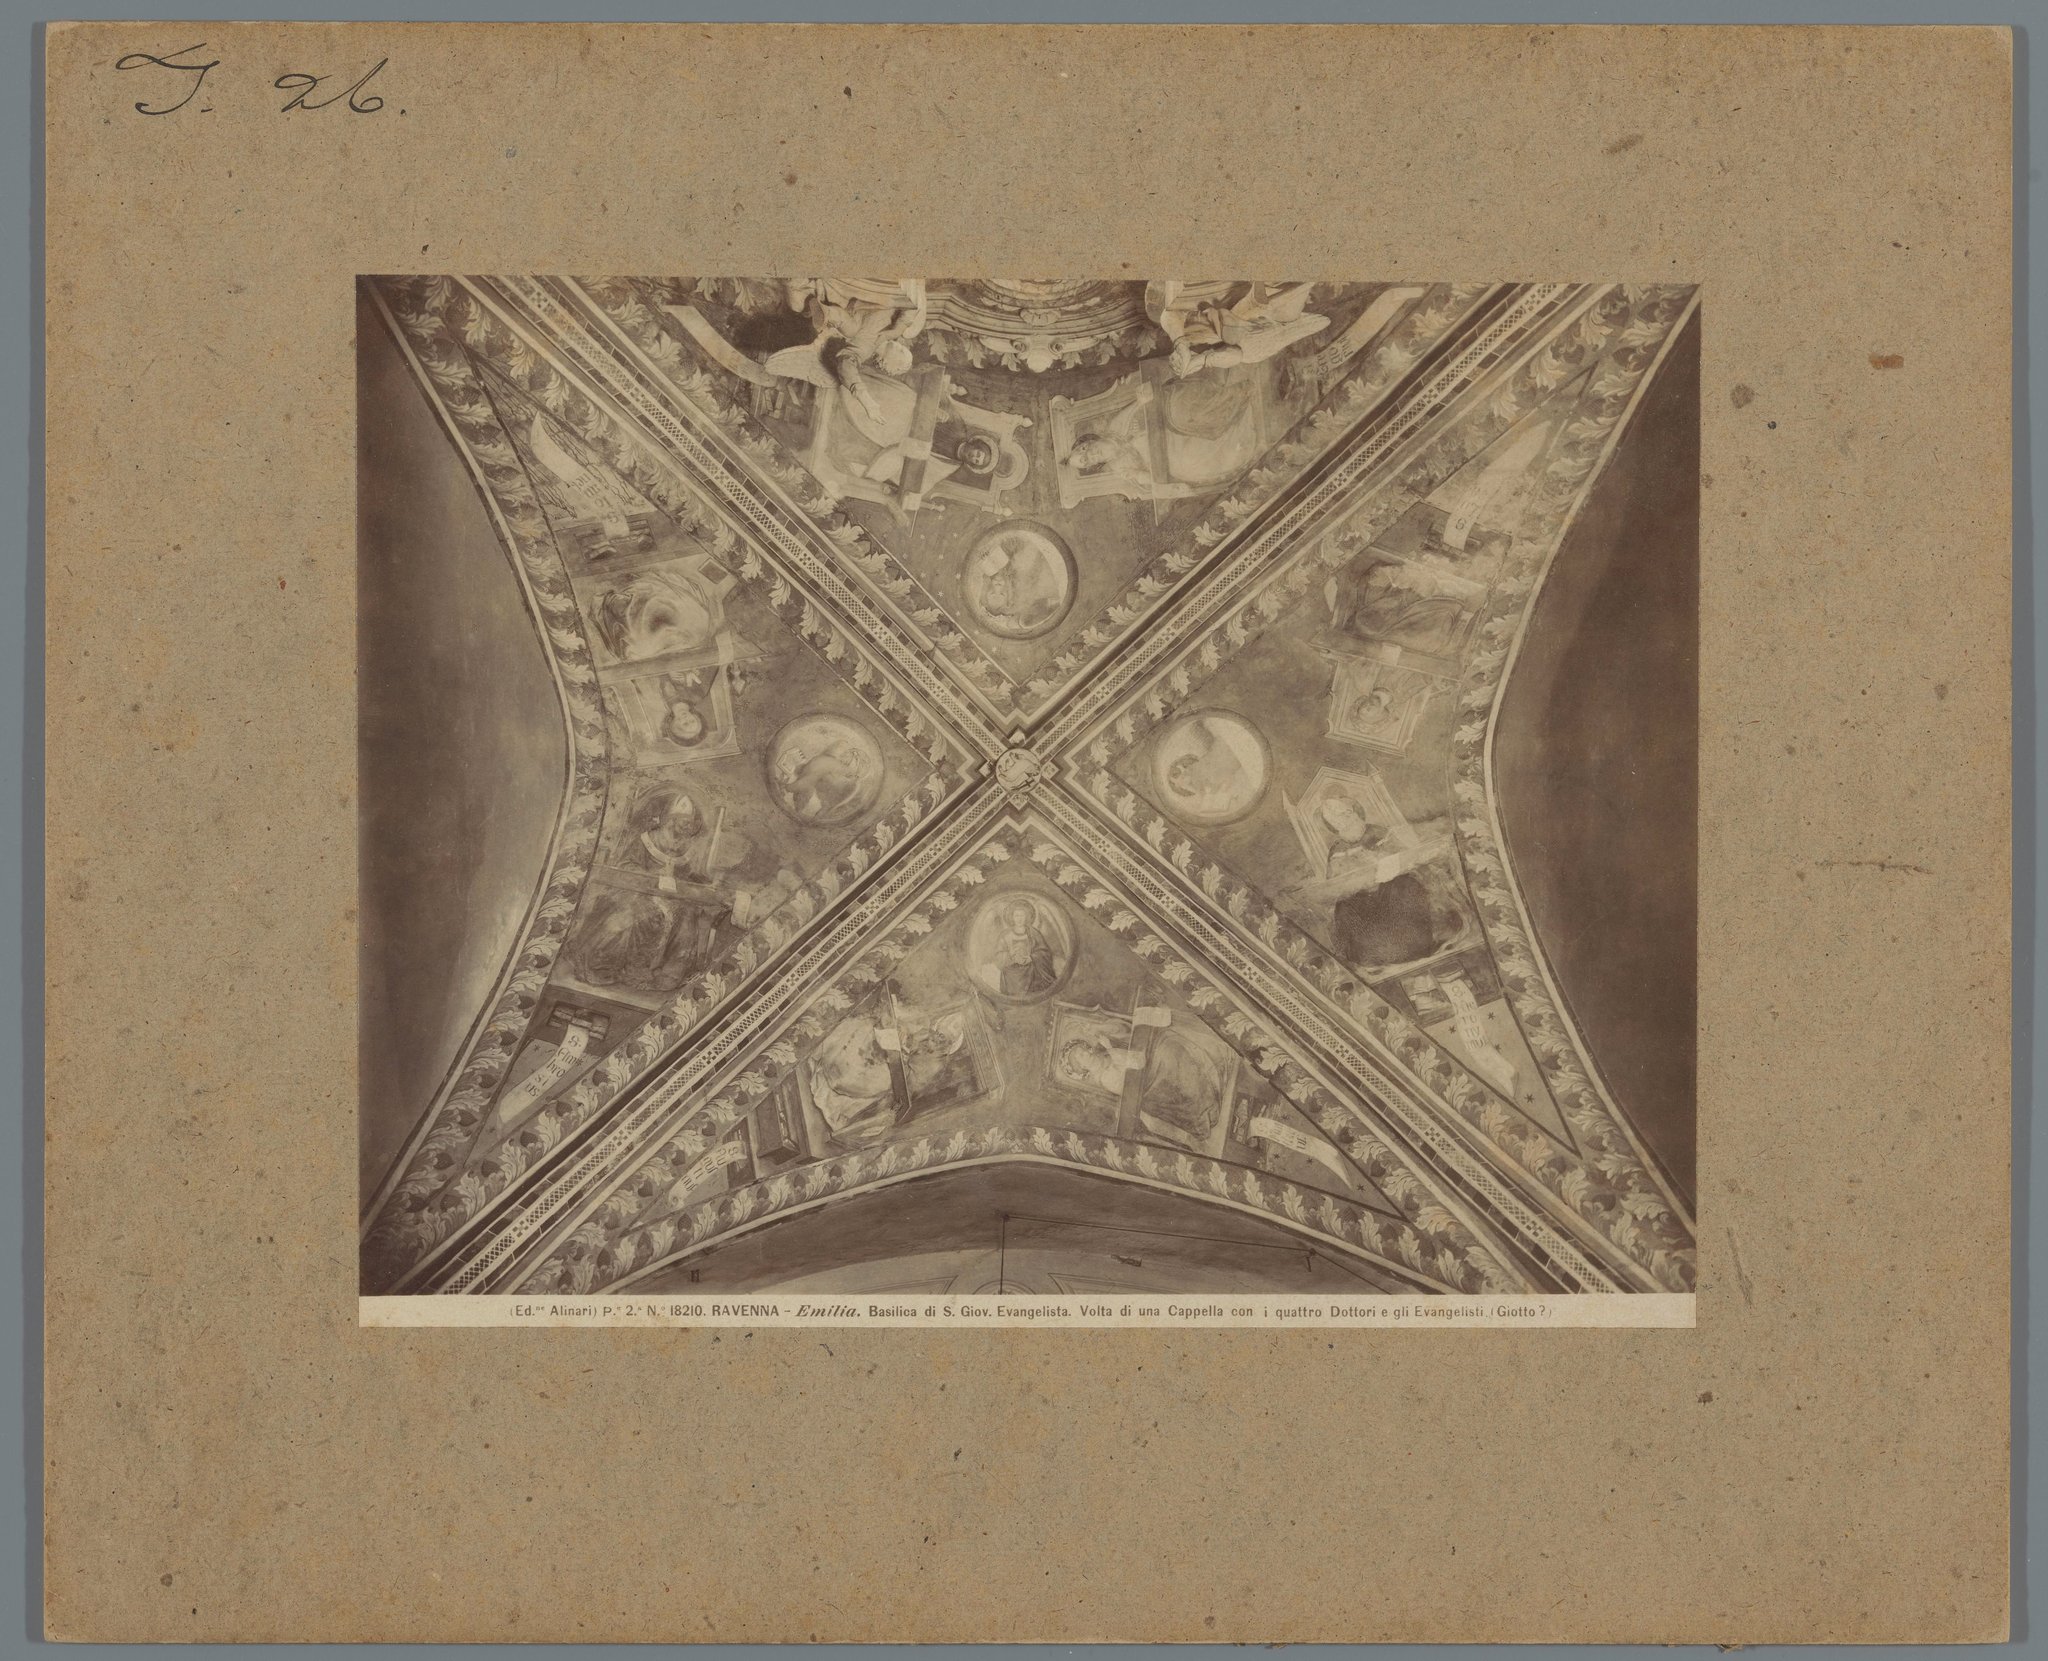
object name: photograph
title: Plafondfresco van de Chiesa di San Giovanni Evangelista te Ravenna, voorstellende de vier westerse kerkvaders en de attributen van de vier evangelisten’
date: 1875-1900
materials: cardboard, photographic support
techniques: albumen print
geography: san giovanni evangelista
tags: the four symbols of the evangelists, 'the apocalyptic beasts', (decorated) ceiling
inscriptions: number: ‘P.e 2.a N.o 18210.’, collector's mark: Lugt 3937